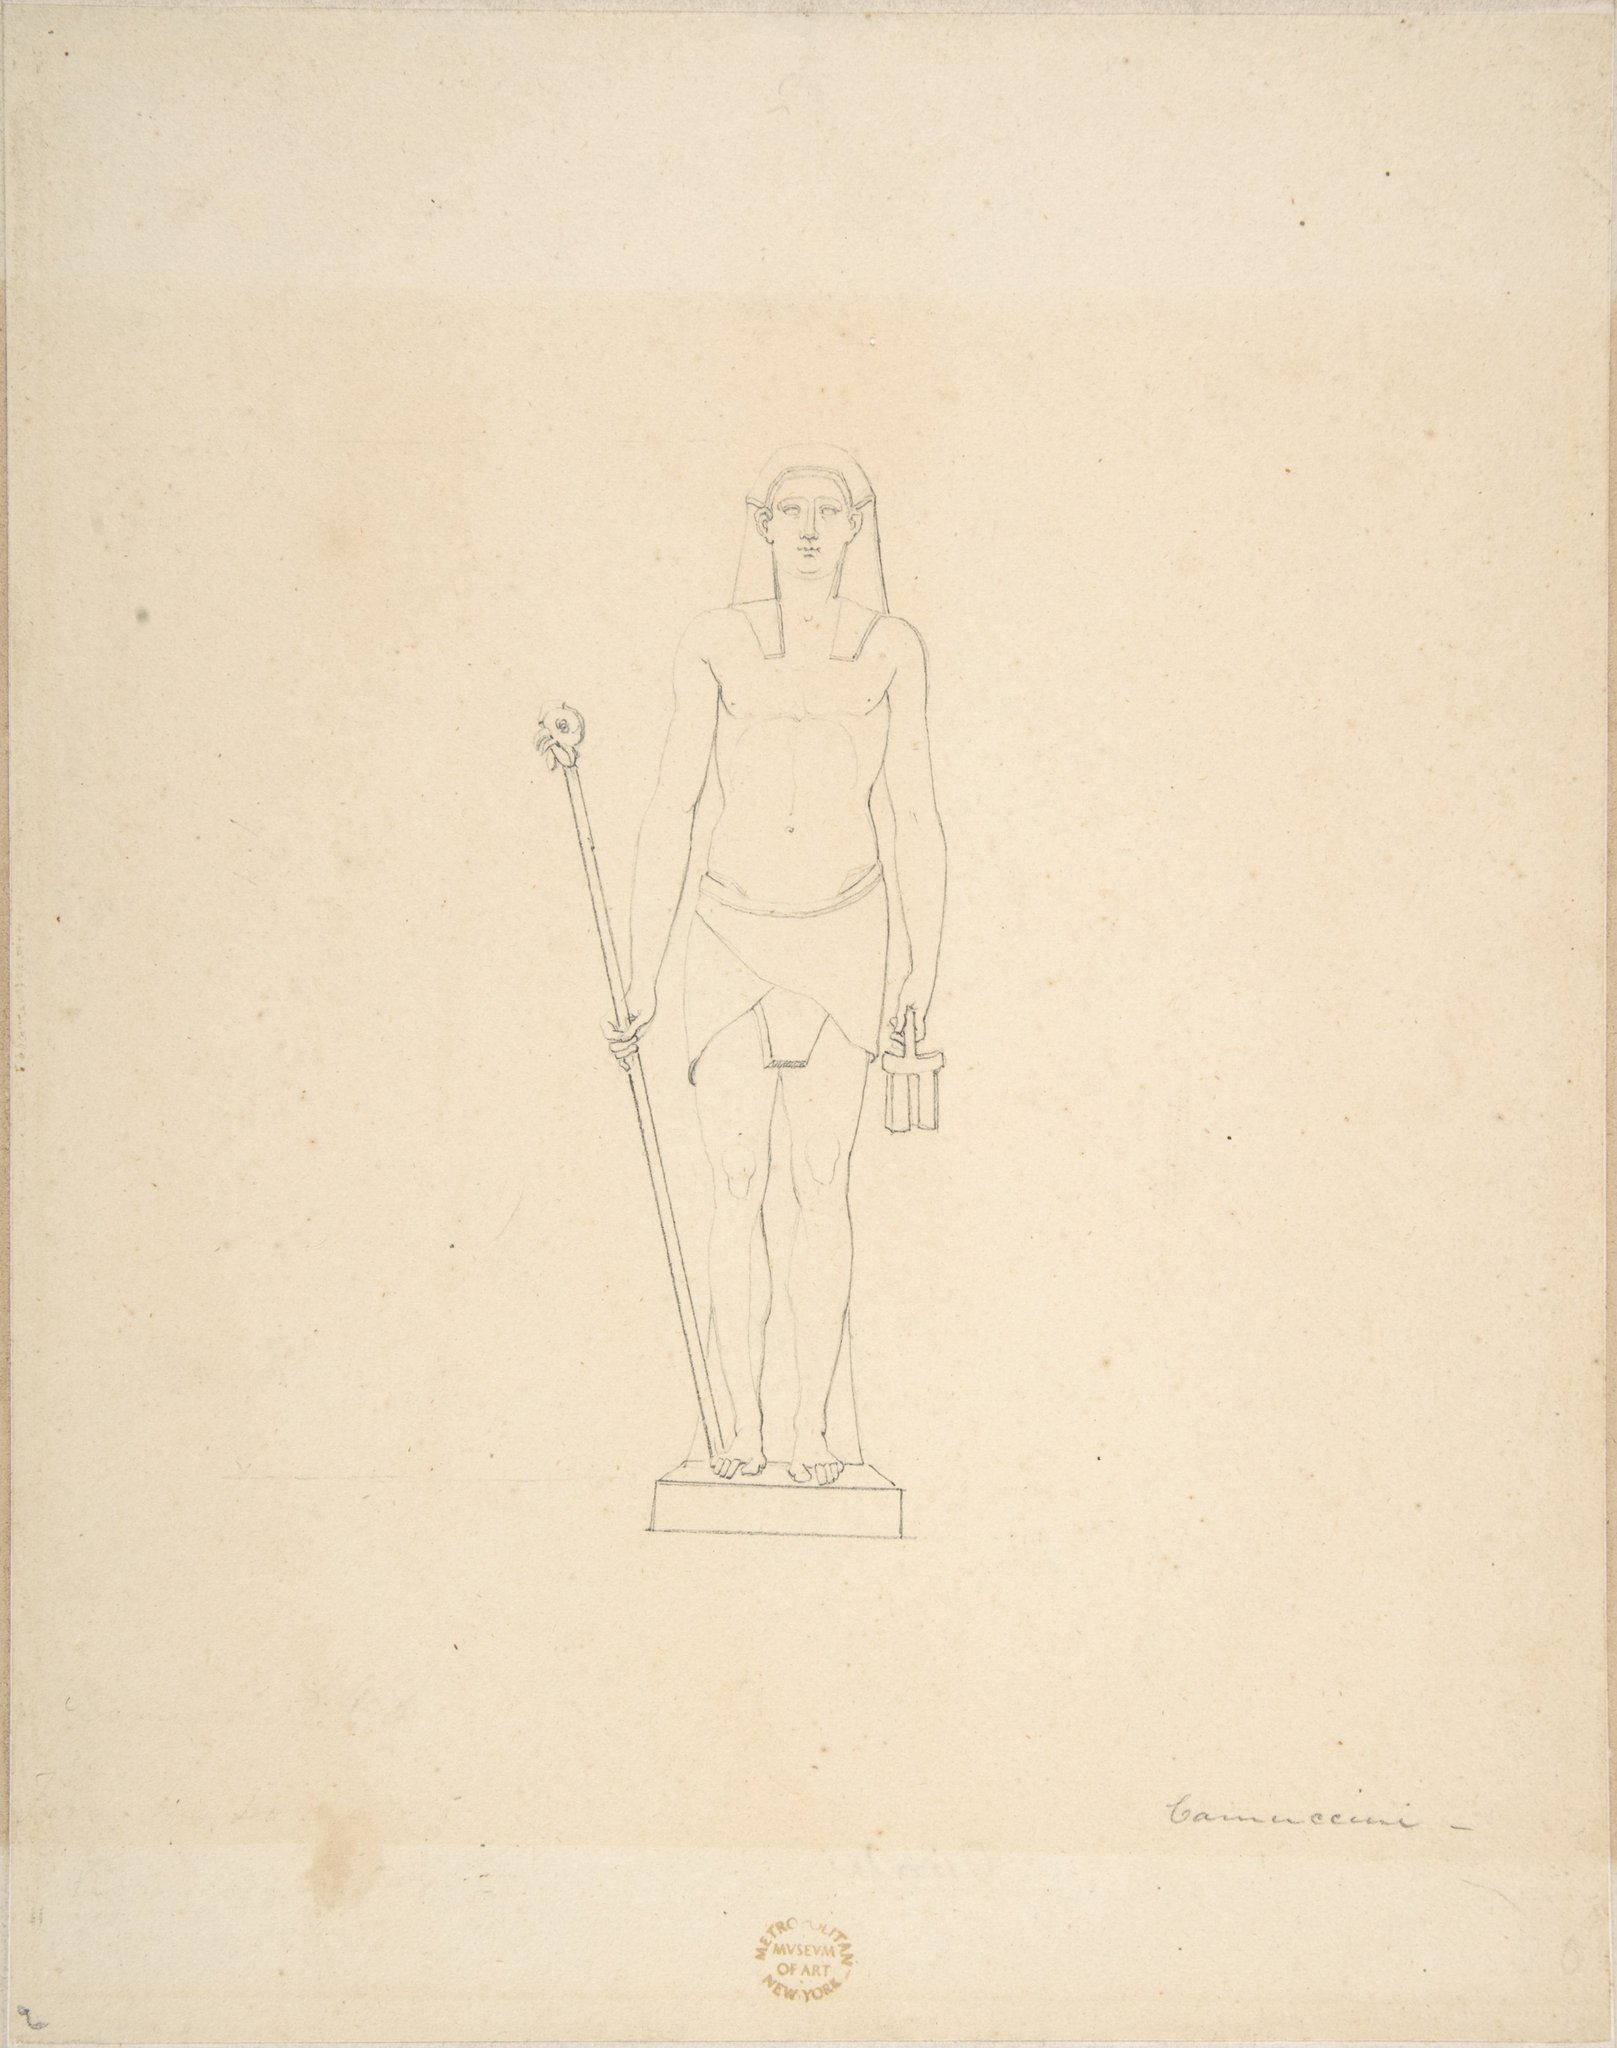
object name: drawing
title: Standing Egyptian Figure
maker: vincenzo camuccini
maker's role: artist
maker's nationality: italian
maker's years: 1771-1844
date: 1795-1844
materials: graphite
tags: men